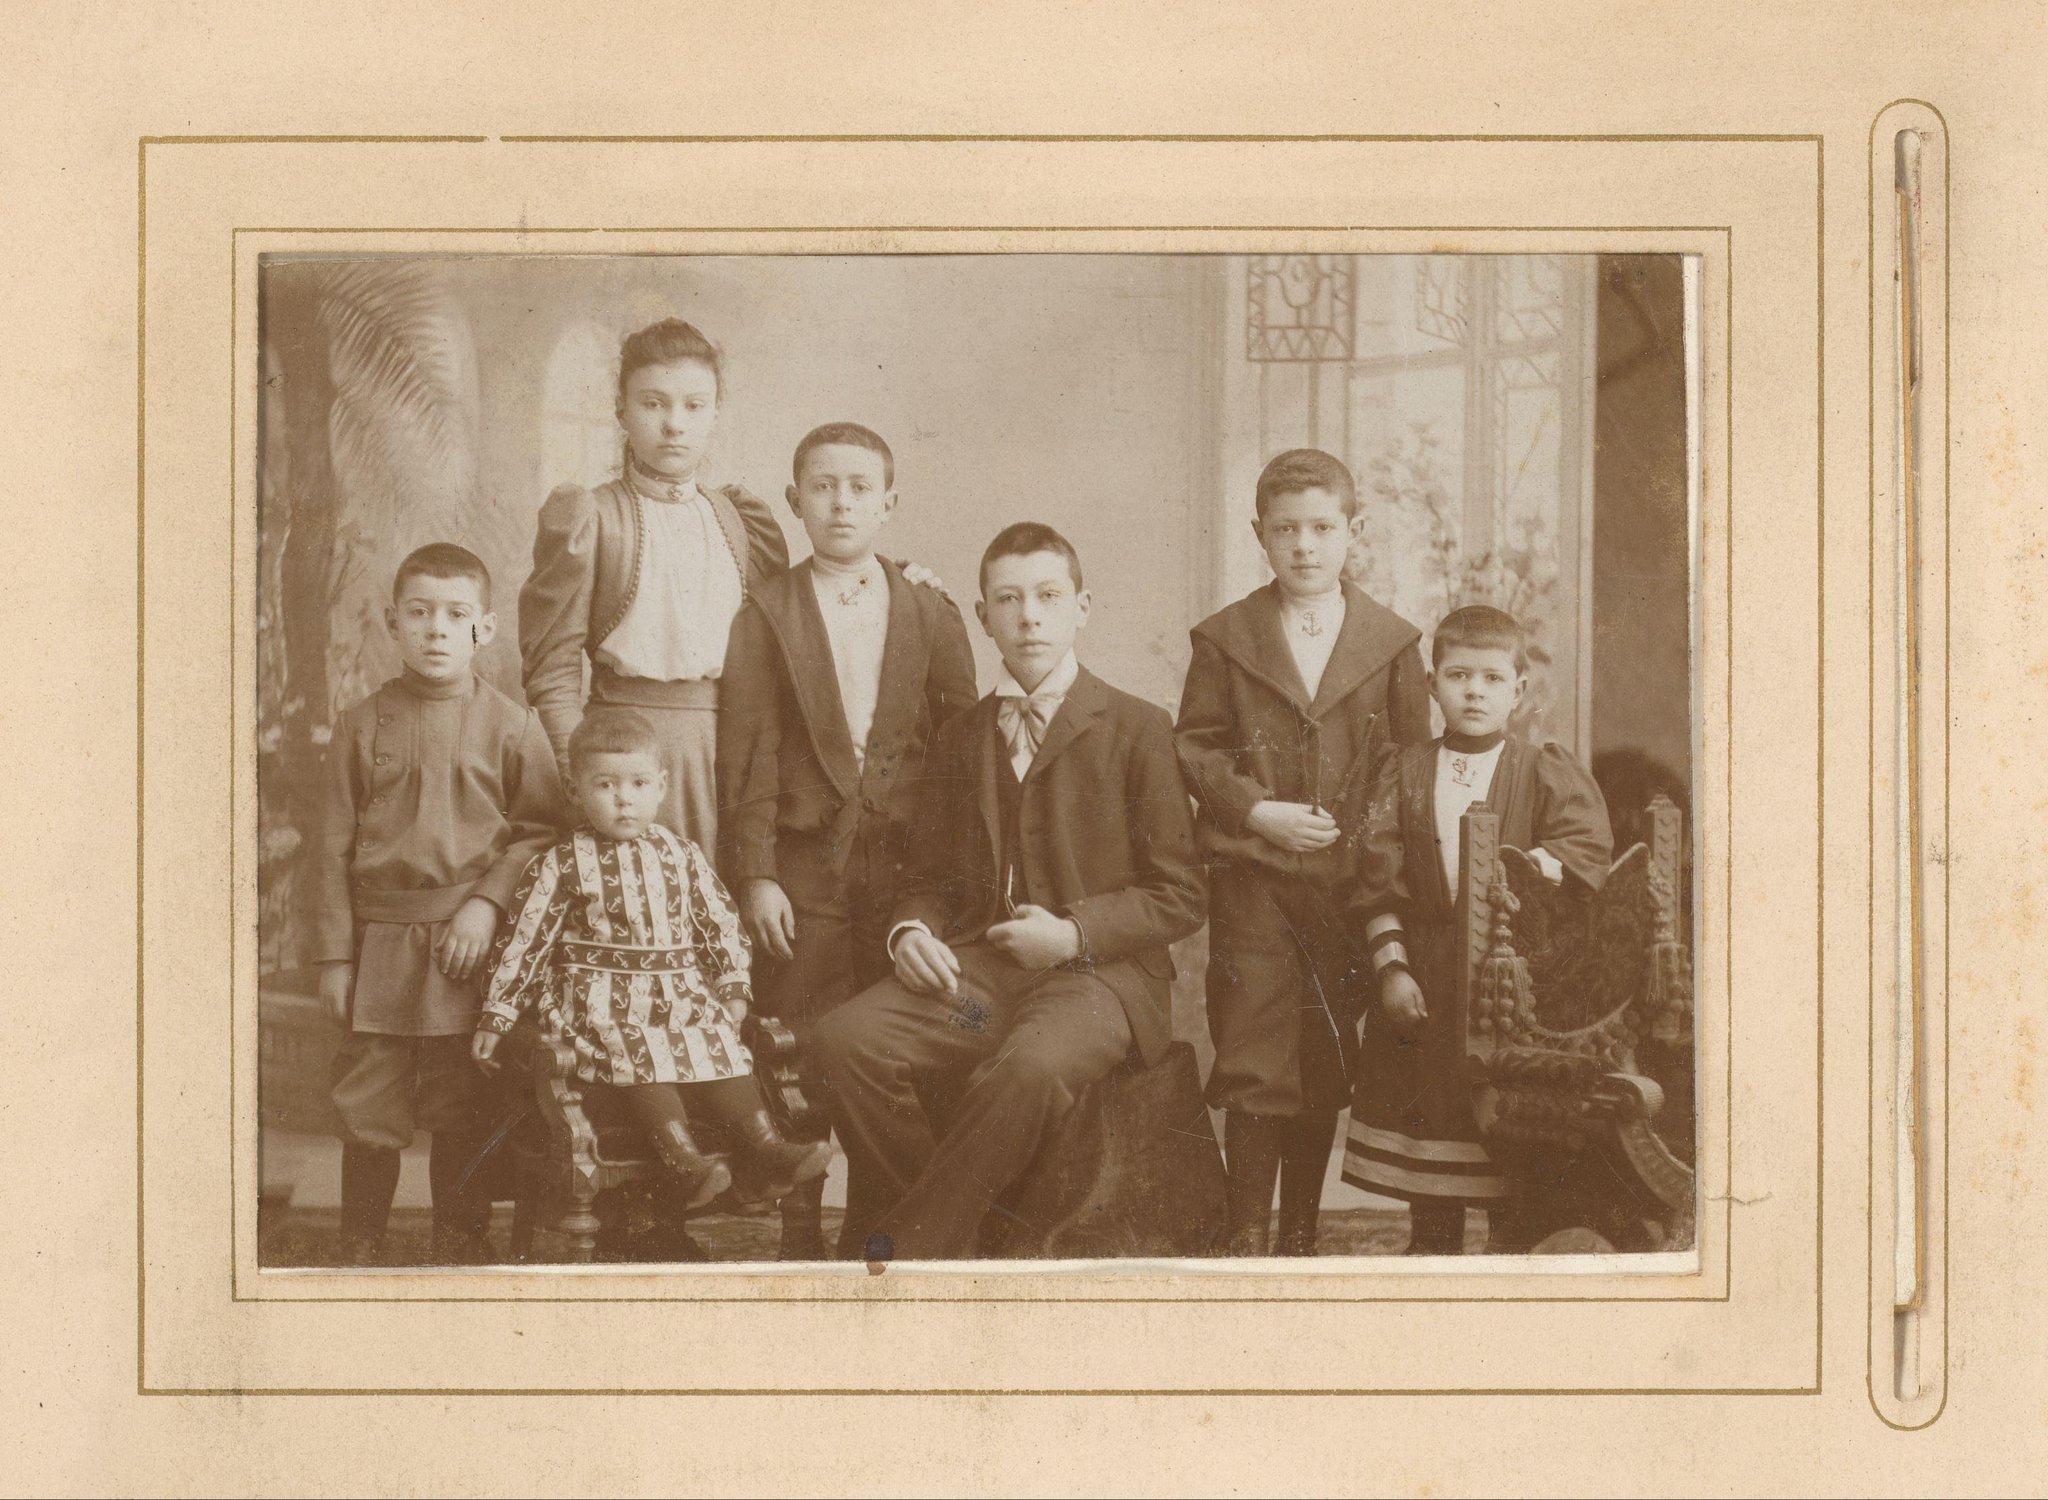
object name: cabinet photograph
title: Groepsportret van zeven kinderen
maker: max büttinghausen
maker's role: fotograaf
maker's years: 1847-1906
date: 1873-1906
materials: cardboard, photographic support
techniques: collodion silver print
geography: amsterdam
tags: youth, young man, adolescent (+ seven persons), anonymous historical persons portrayed in a group, in a group-portrait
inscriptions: annotation: ‘Lamise/ Emmanuel/ Max/ George - 1 Adrien/ Rene/ Marie Therèse’, inscription: ‘M. Büttinghausen/ Amsterdam Kalverstraat hoek Spui/ eenig Atelier/ Specialiteit in Vergrootingen./ Onveranderlijke/ Kooldruk/ De plaat blijft ter/ nabestelling bewaard.’